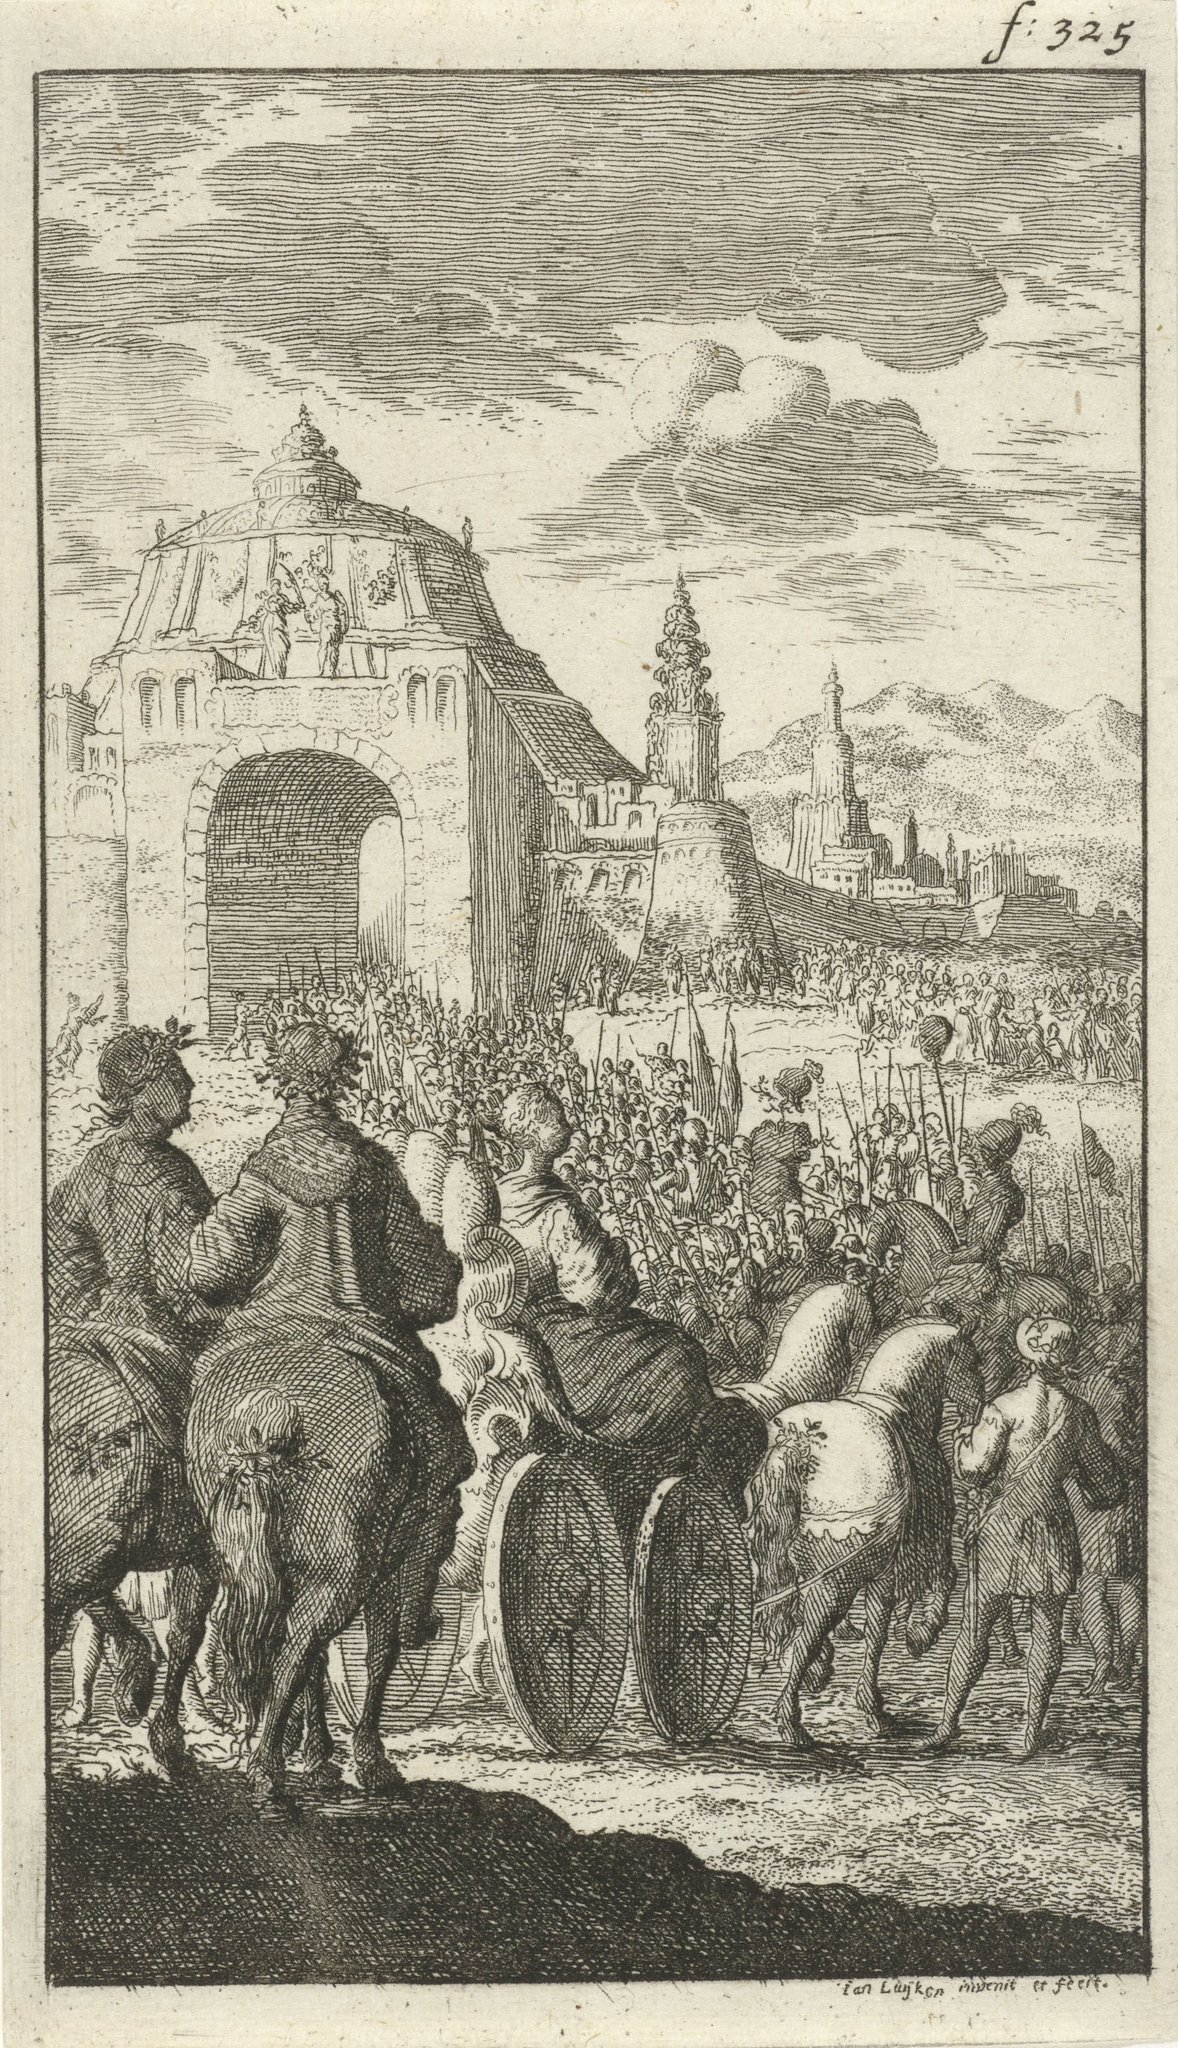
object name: book illustration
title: Triomftocht van Argenis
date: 1680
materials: paper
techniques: etching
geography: amsterdam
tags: conqueror triumphing, triumphal entry of victor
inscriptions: collector's mark: Lugt 2228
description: Illustratie opgenomen in het eerste deel van: Barclay, John. D'Argenis, 2 delen. Amsterdam: Jan Claesz ten Hoorn, 1680-1681.